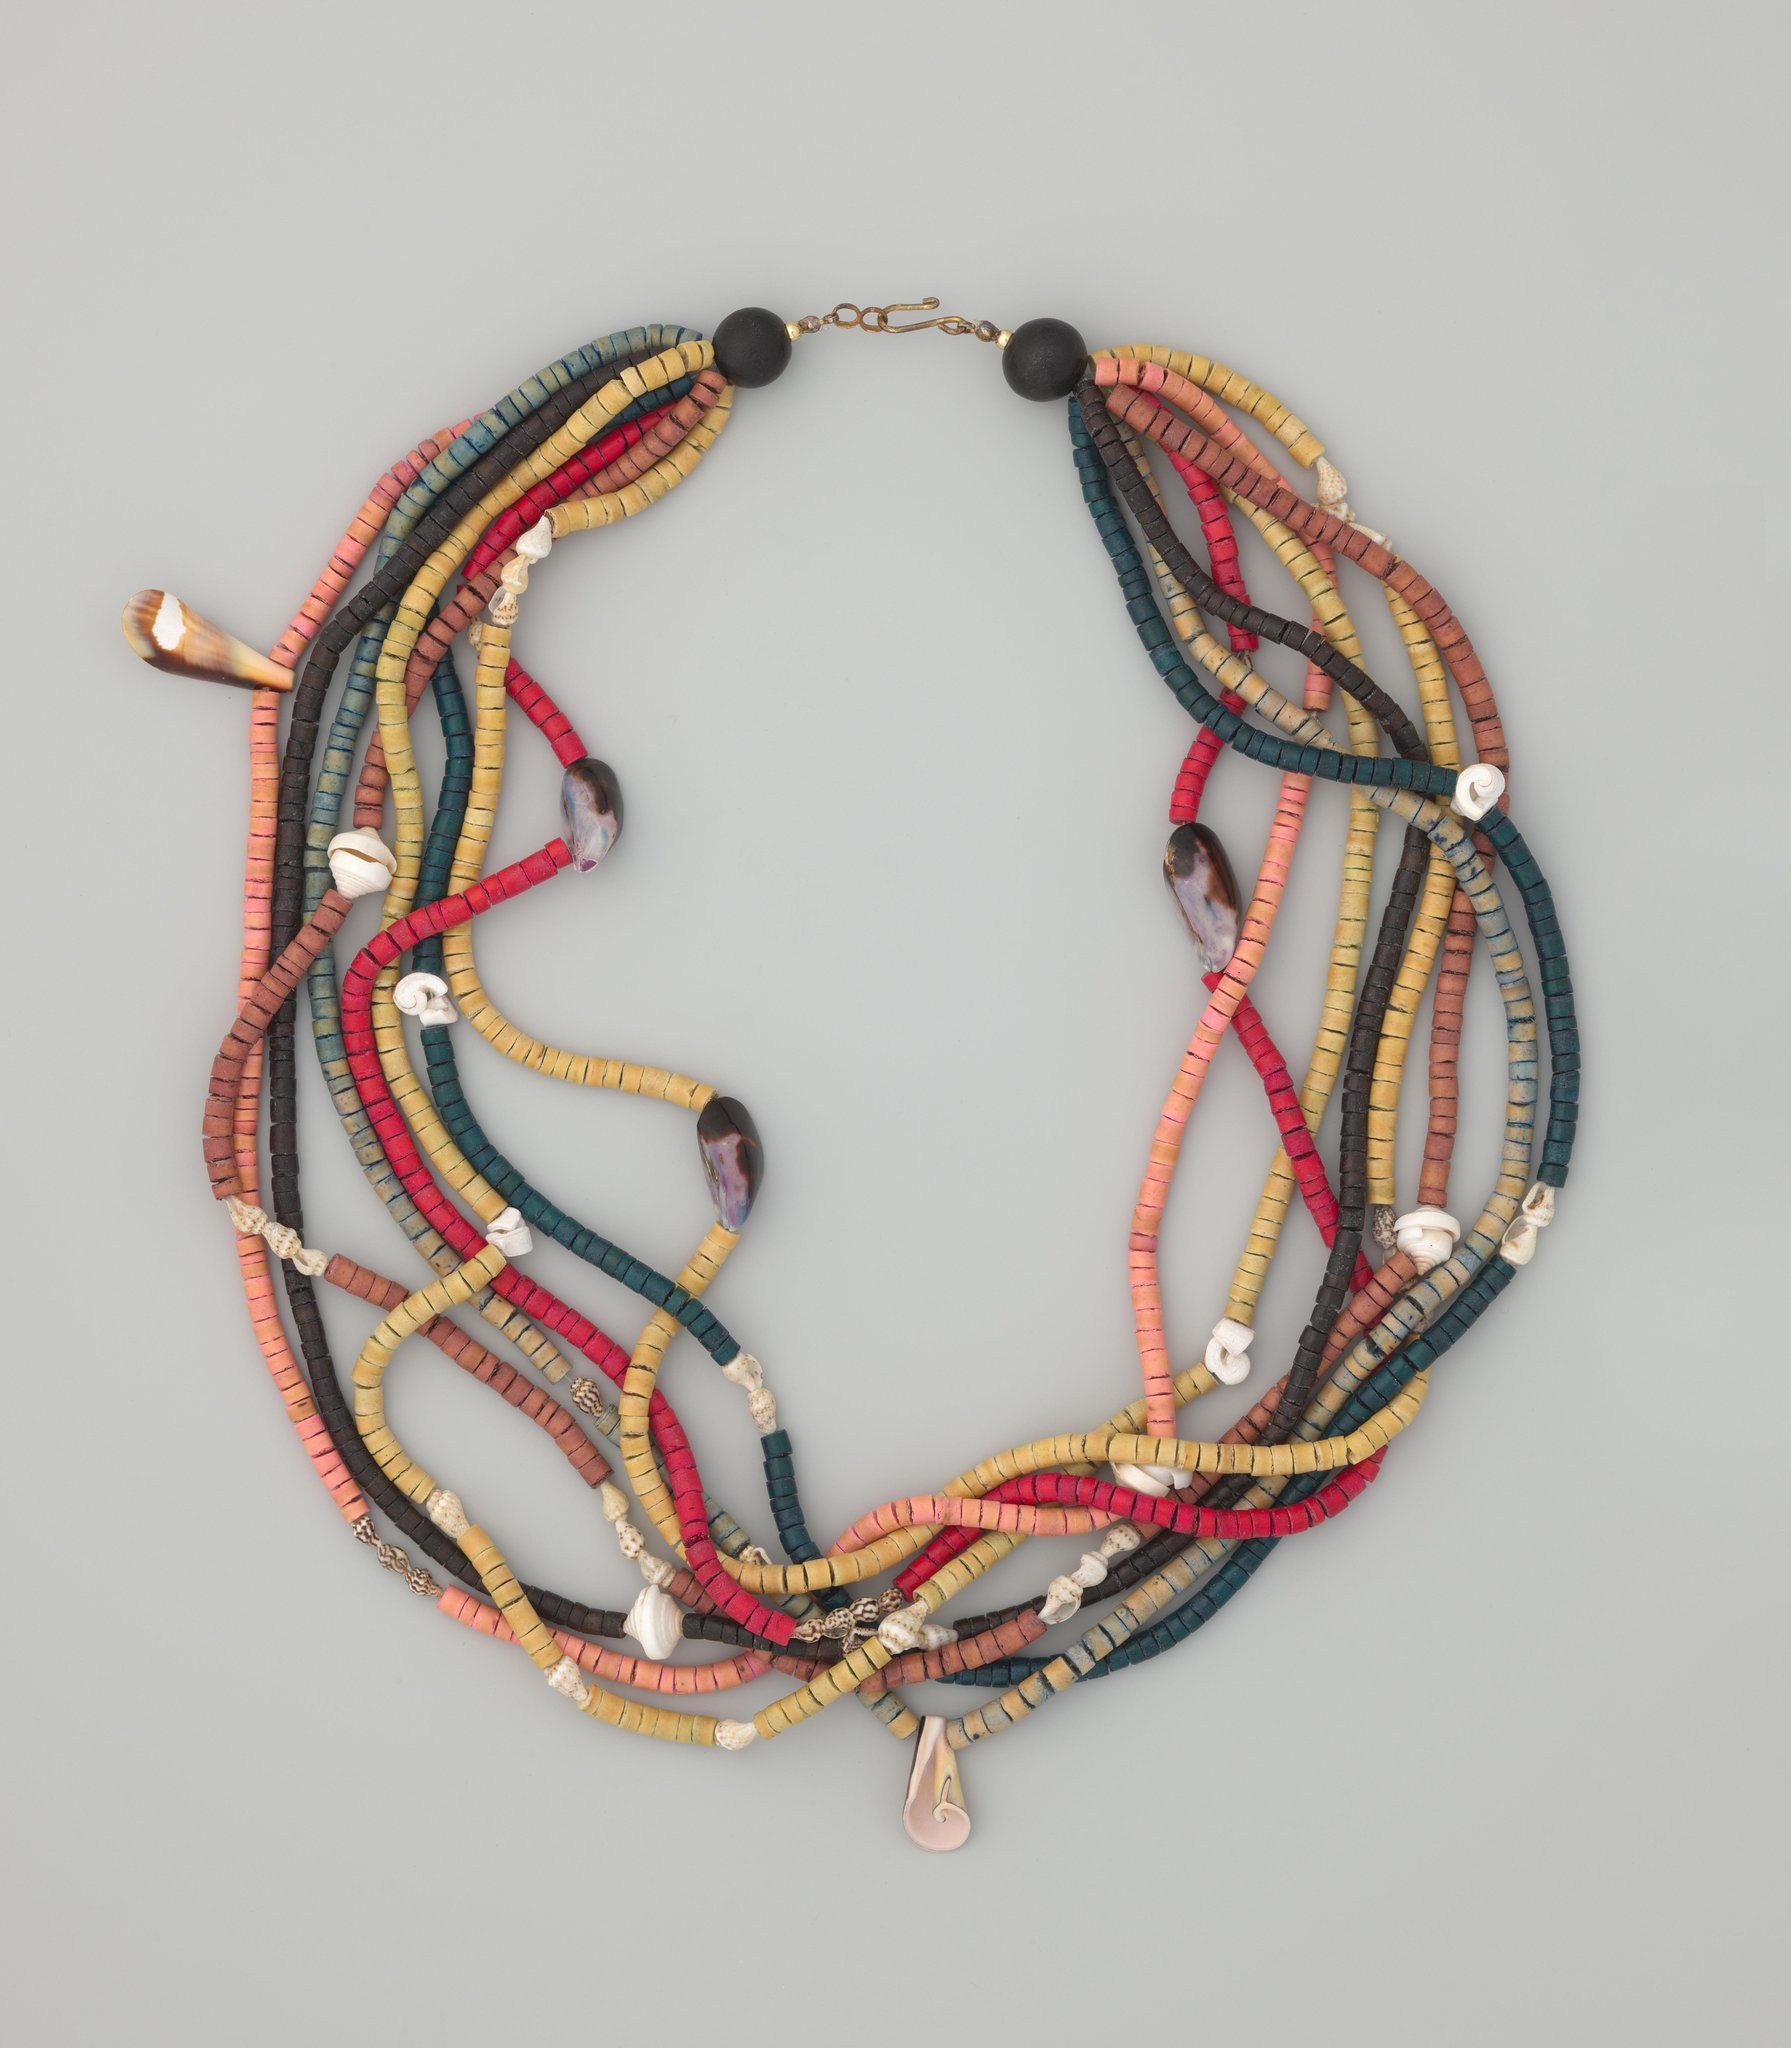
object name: necklace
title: Collier van kralen en schelpen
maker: Anonymous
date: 1999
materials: metal, shell, yarns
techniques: sewing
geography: philippines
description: Collier van acht strengen kralen met sluiting door middel van een oog en een haak van metaal aan zwarte bollen. De strengen hebben allemaal een andere kleur en de kralen in de strengen worden afgewisseld met verschillende soorten schelpen.